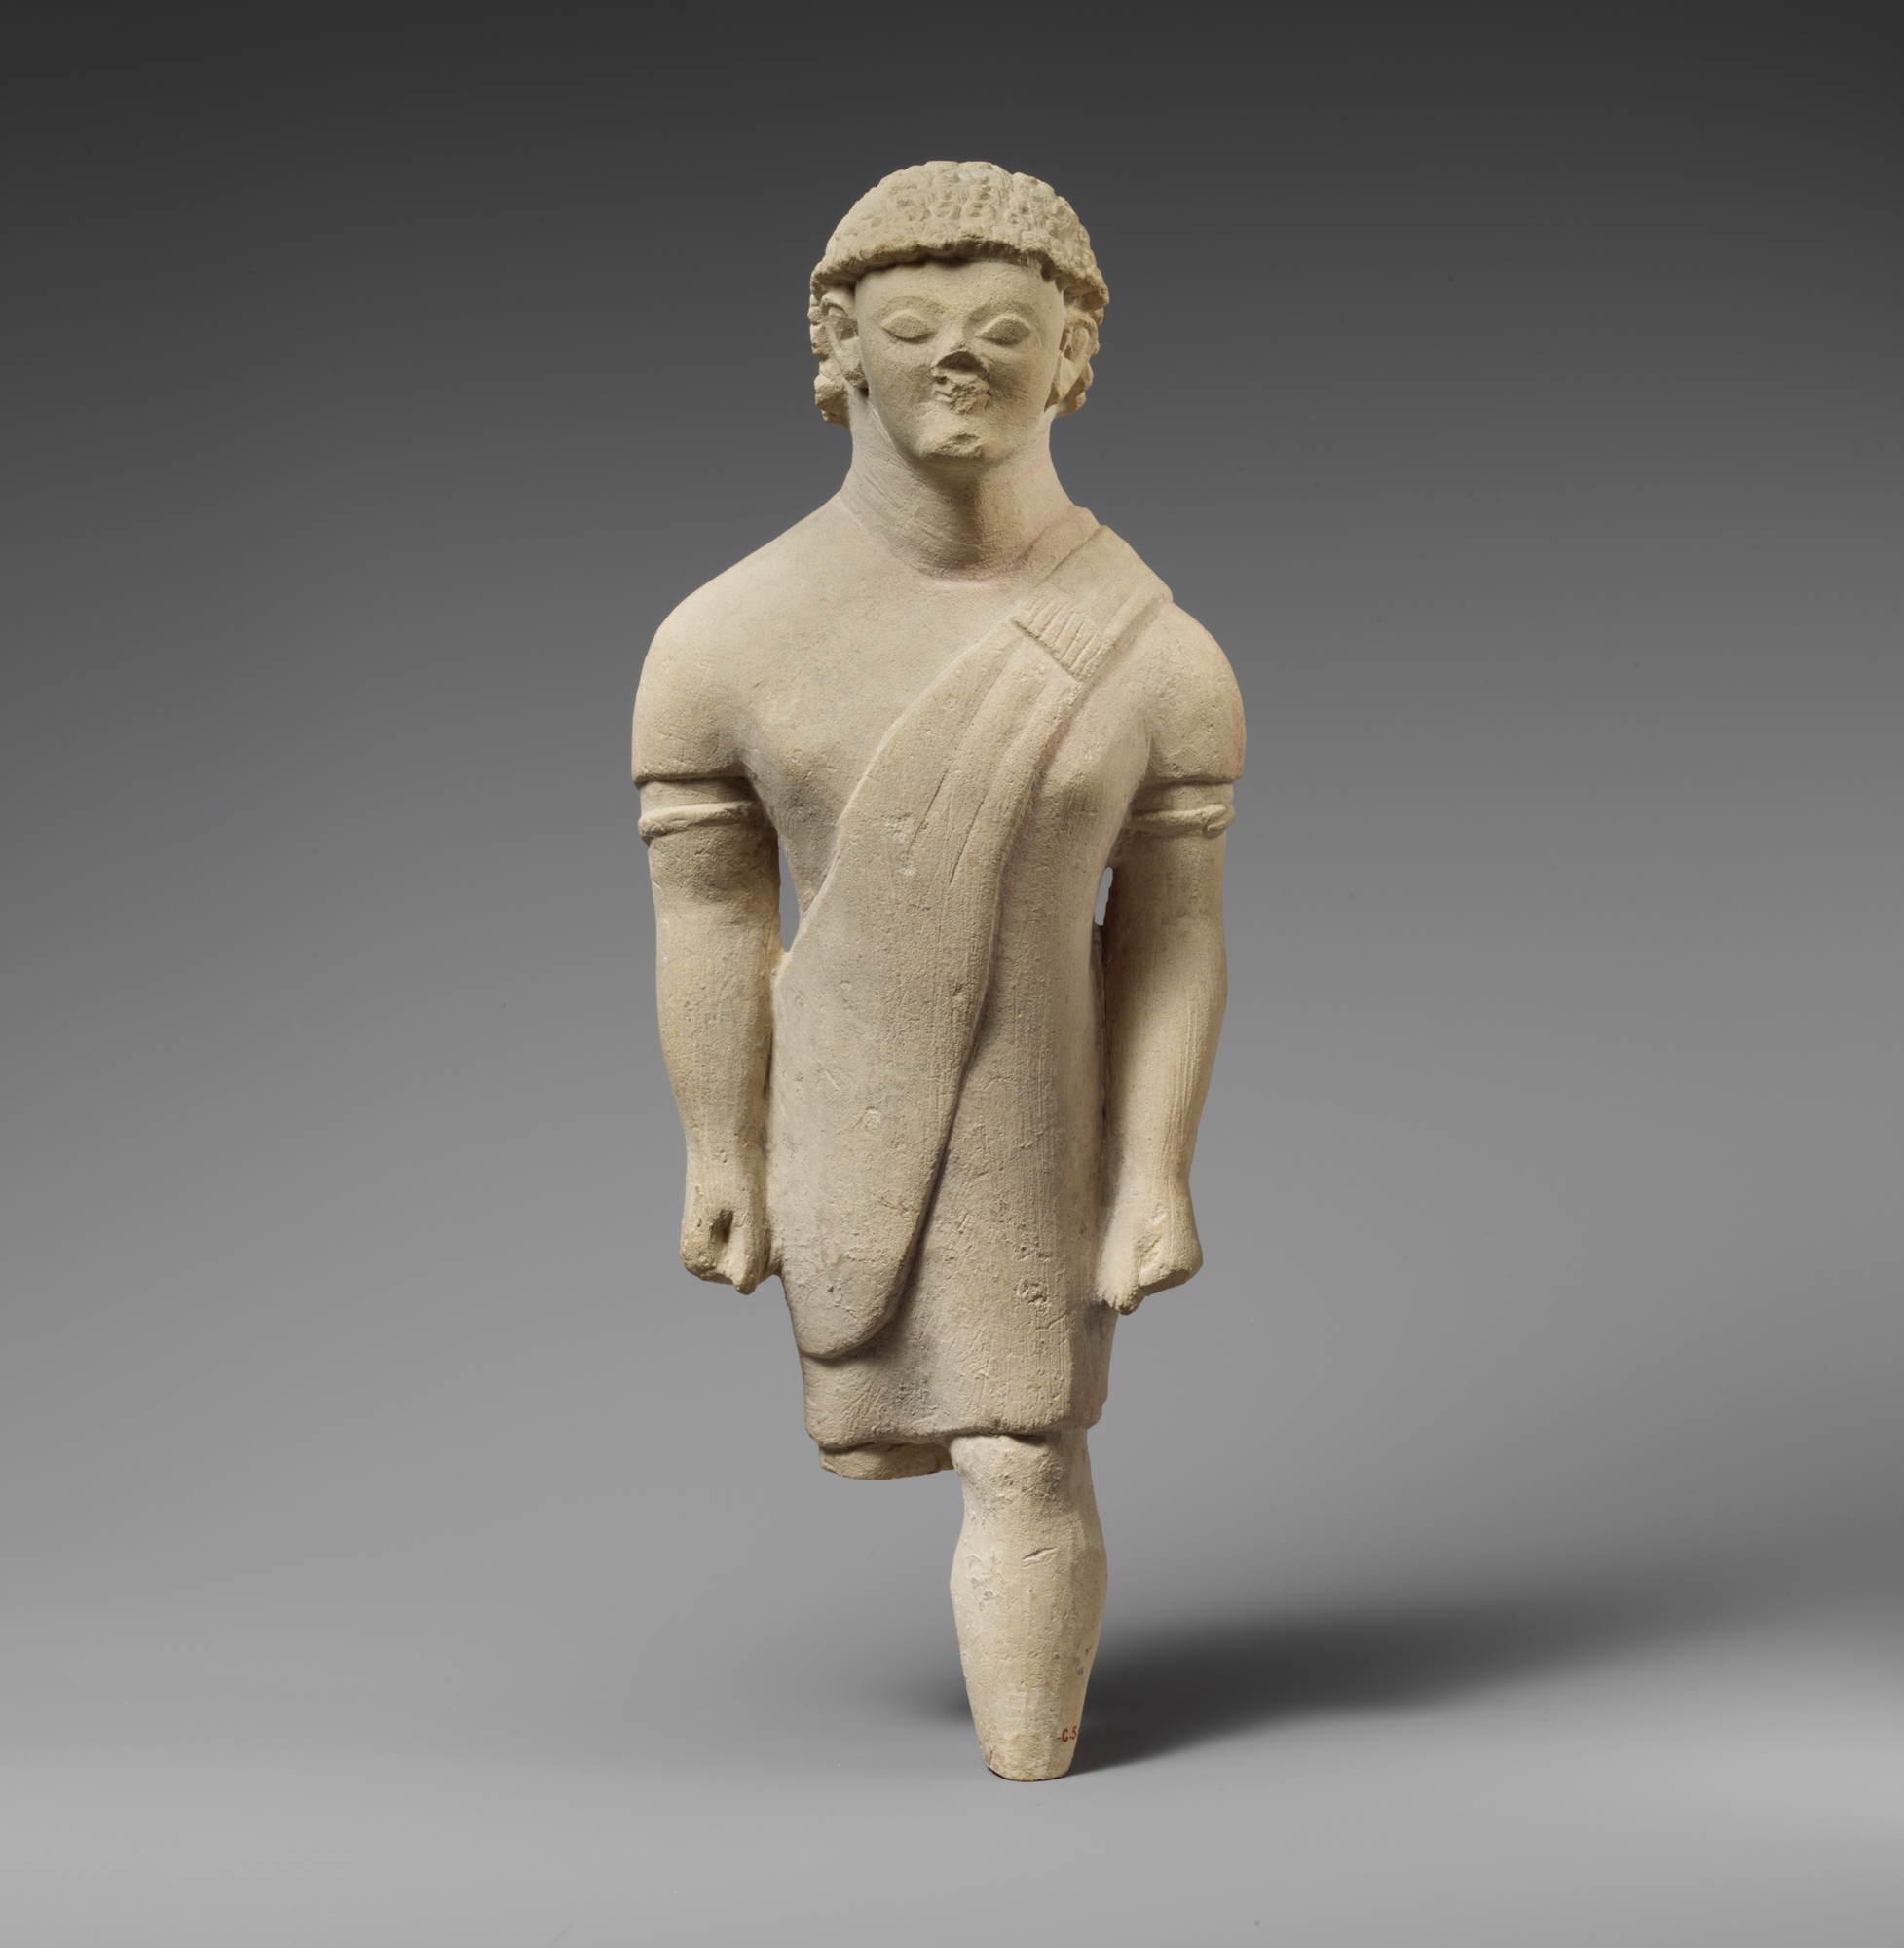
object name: statuette of a votary, male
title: Limestone statuette of a beardless male votary in Greek dress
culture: cypriot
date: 534-501 BCE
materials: limestone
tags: men